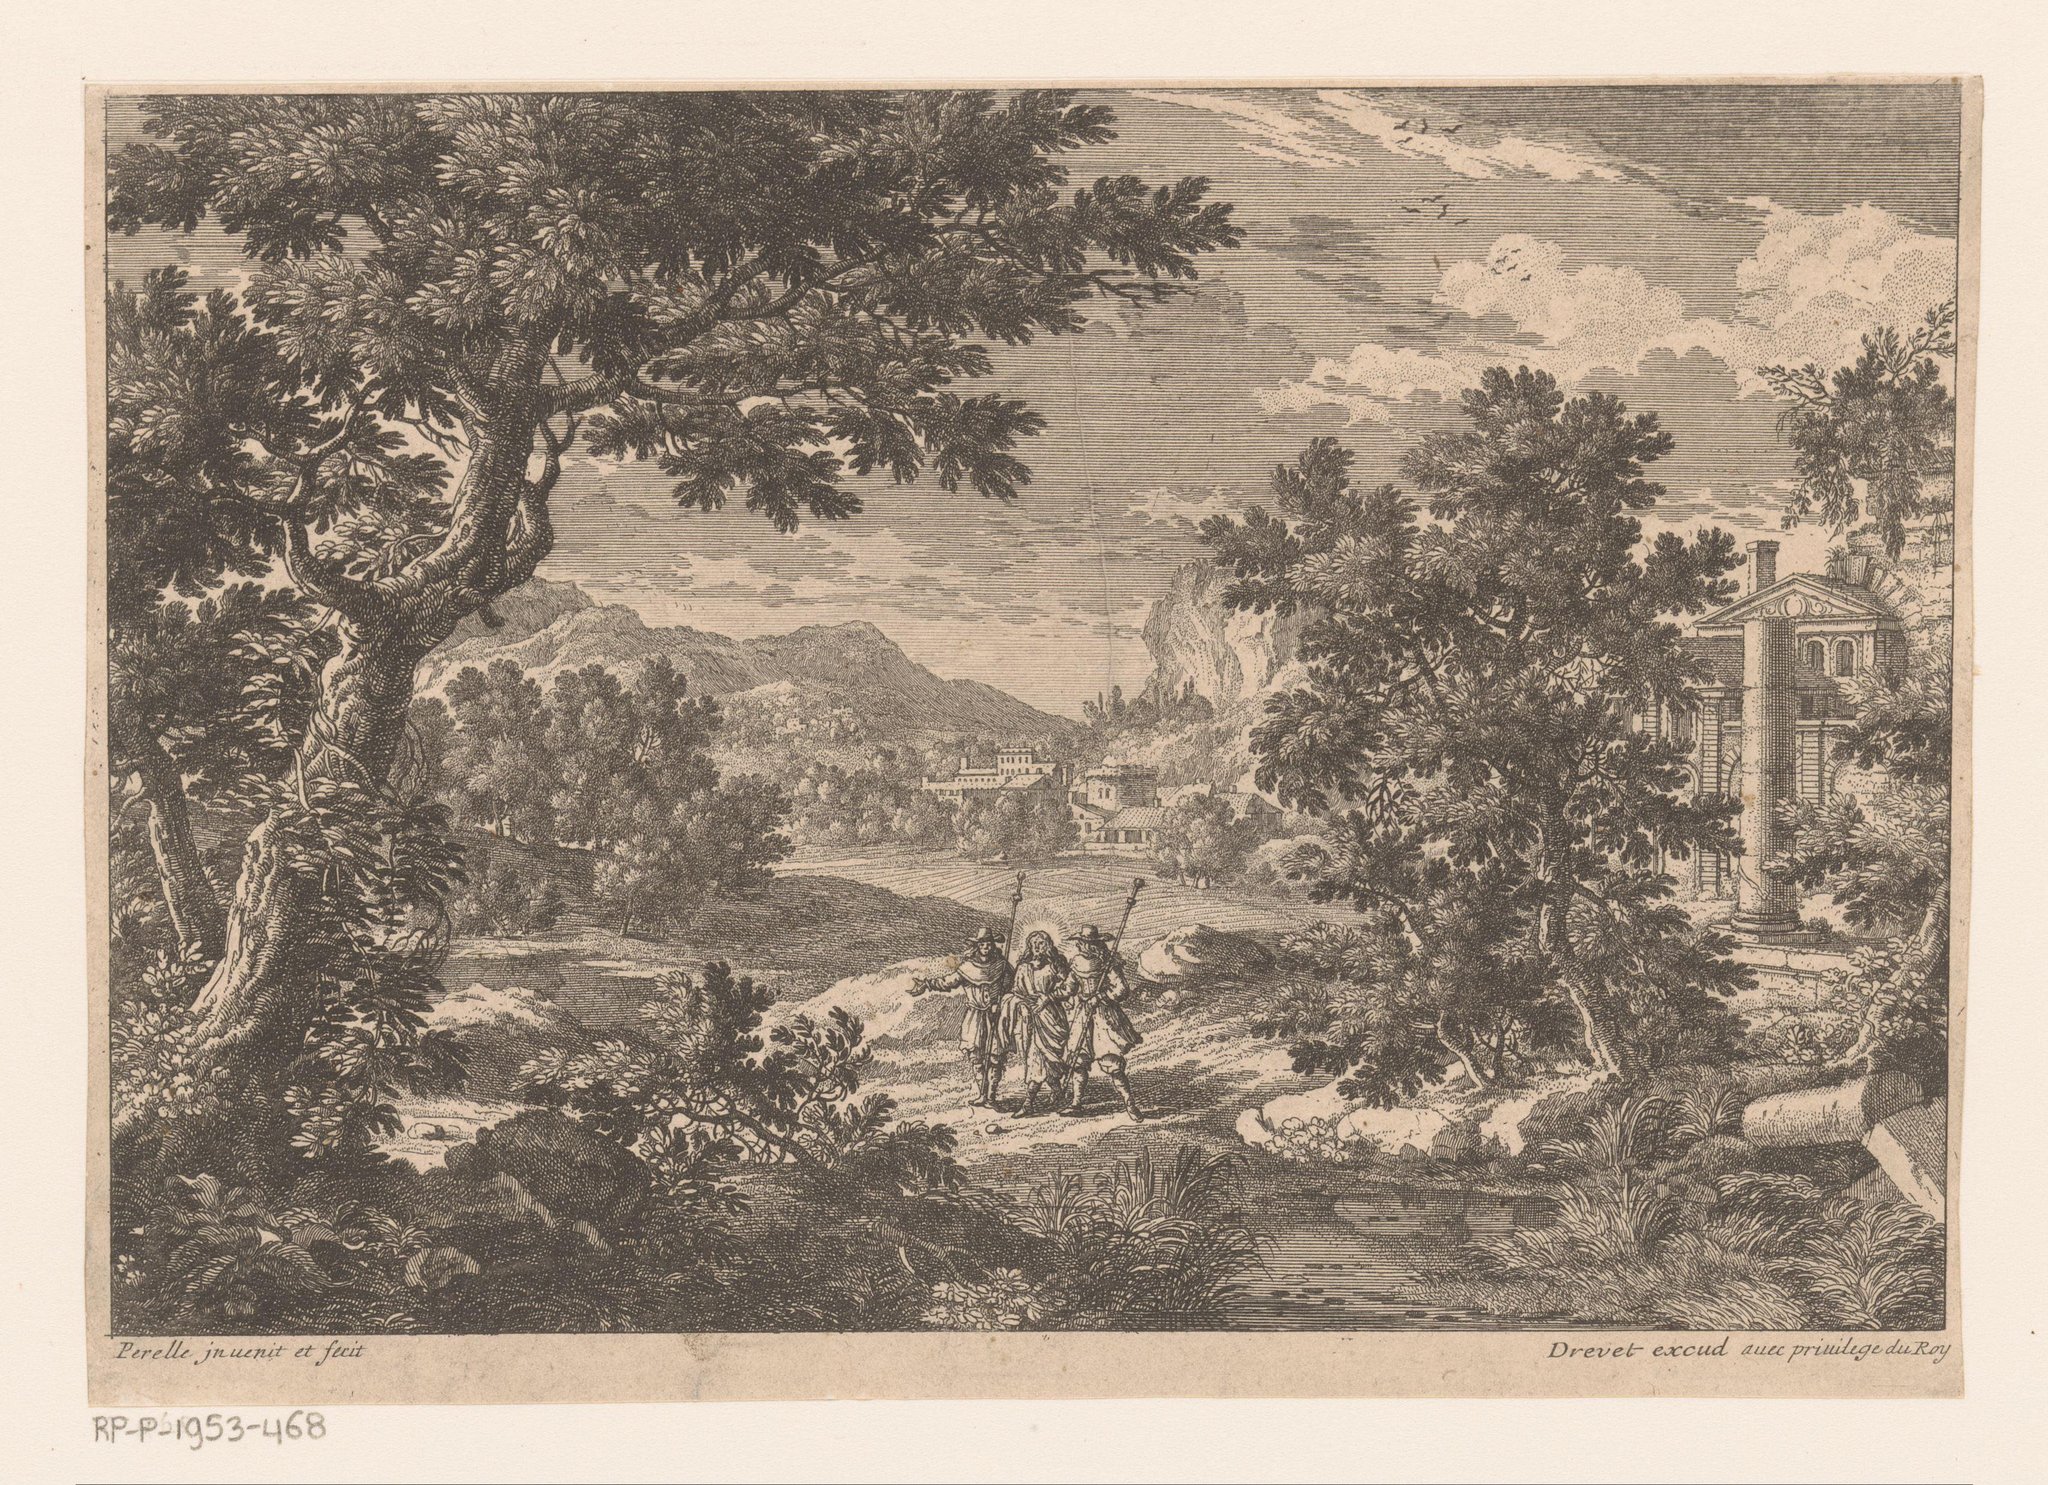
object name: print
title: Landschap met de Emmaüsgangers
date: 1673-1695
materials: paper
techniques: etching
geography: france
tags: the journey to emmaus: two disciples (cleopas and peter) under way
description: Prenten met het signatuur 'Perelle' kunnen zowel door vader Gabriel als door zonen Nicolas en Adam gemaakt zijn.